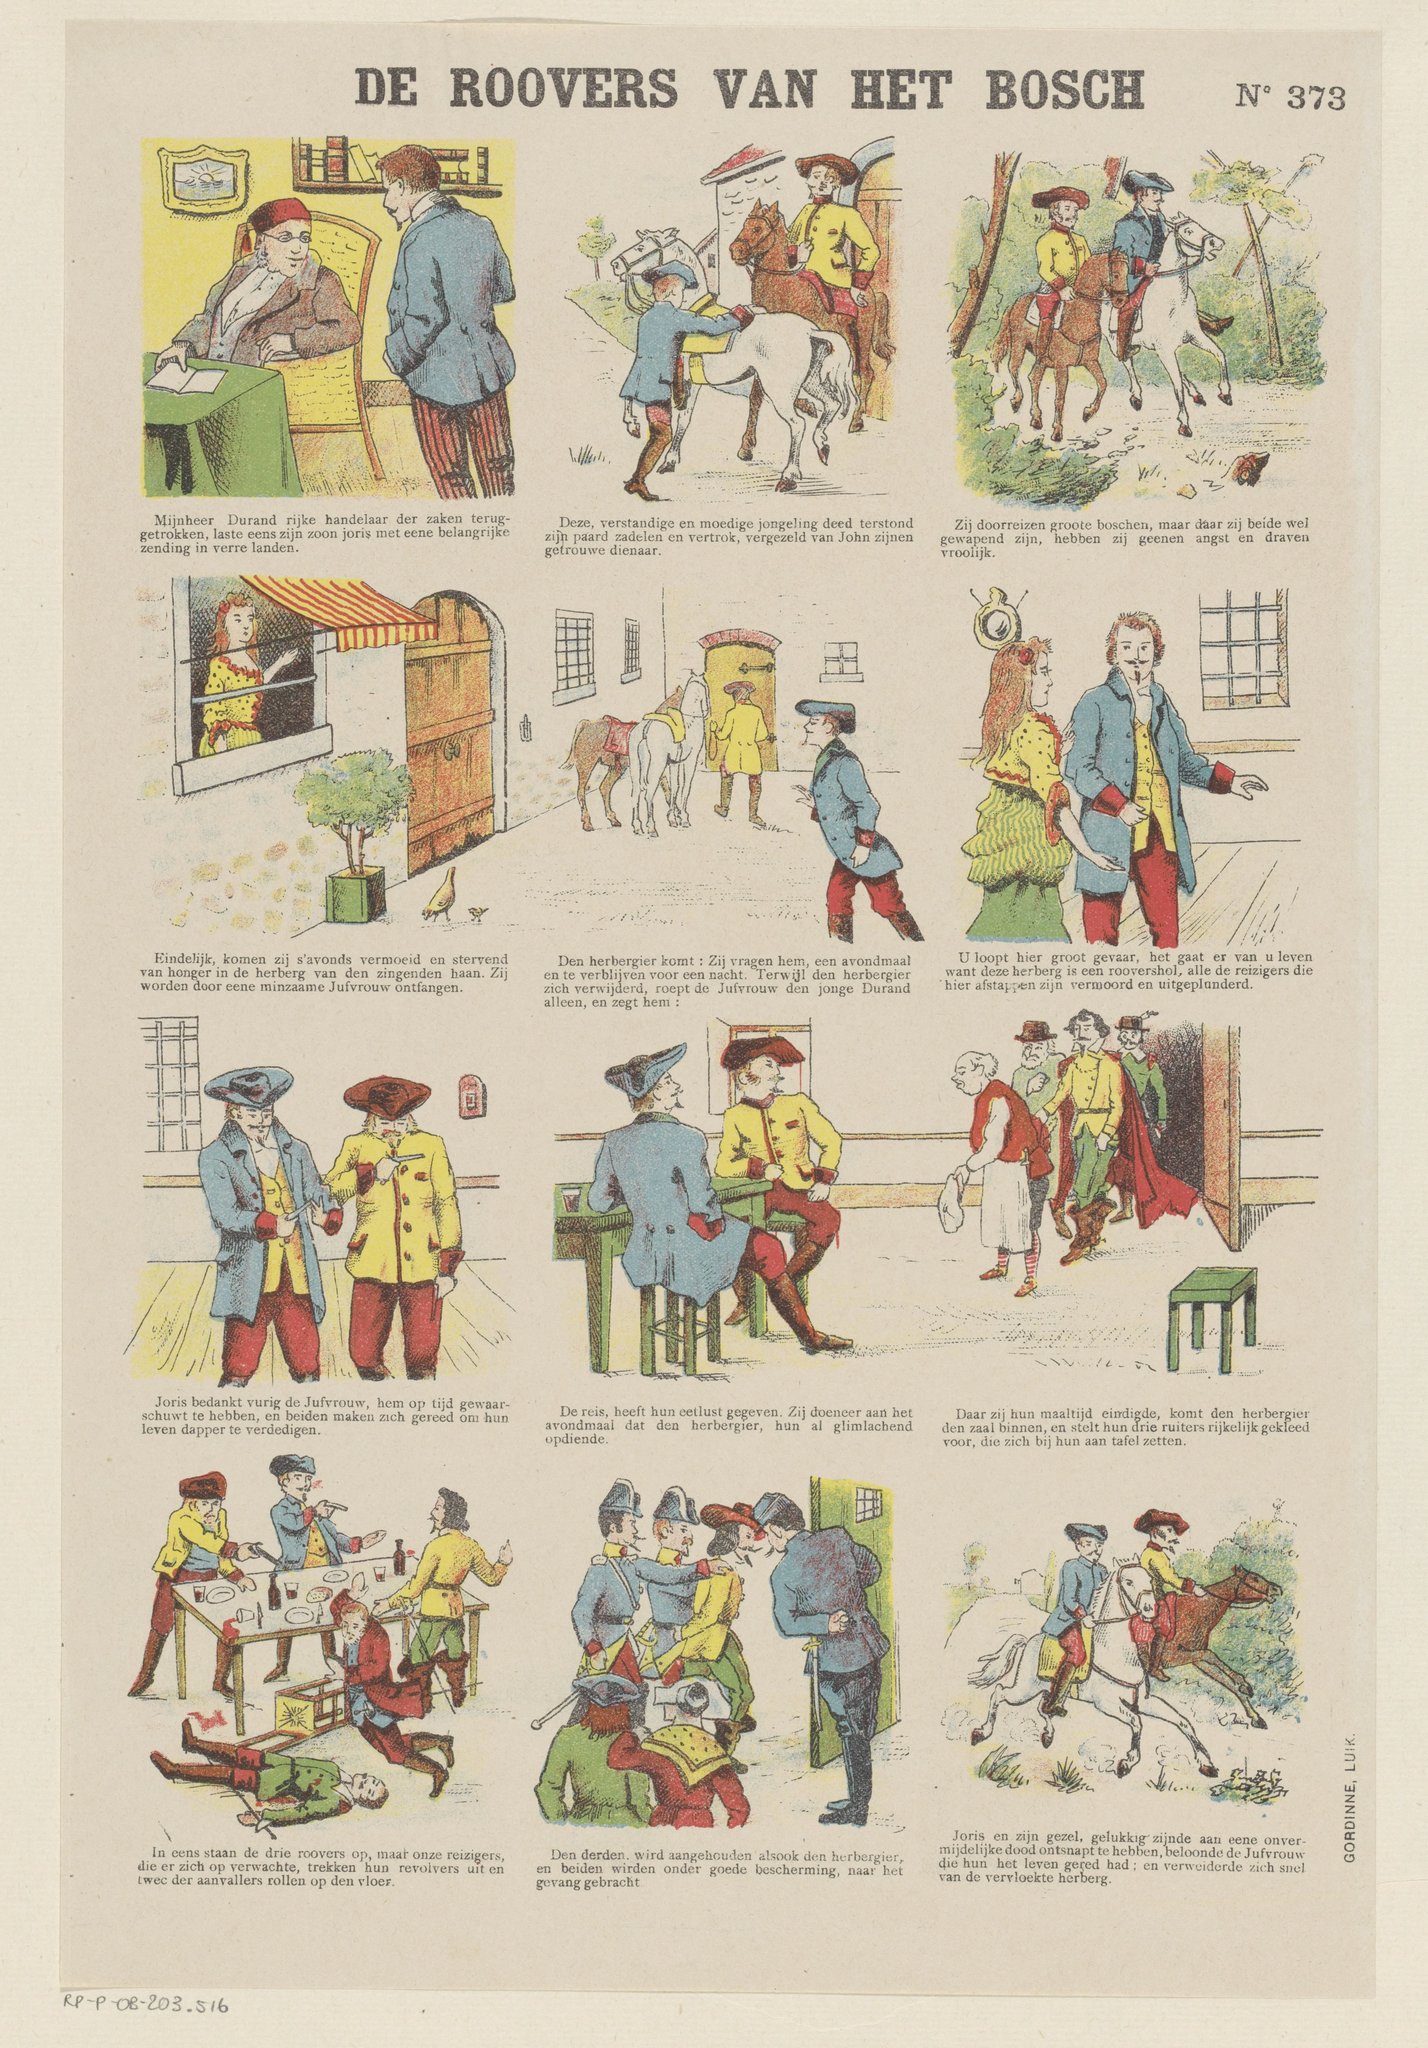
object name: print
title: De roovers van het bosch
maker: Anonymous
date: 1894-1959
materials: paper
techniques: lithograph, letterpress printing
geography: liège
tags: hotel, hostelry, inn (+ rest ~ travelling), attack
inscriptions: collector's mark: Lugt 2760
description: Blad met 12 voorstellingen over Joris en John die aangevallen worden in een herberg. Onder elke afbeelding een onderschrift. Genummerd rechtsboven: No 373.